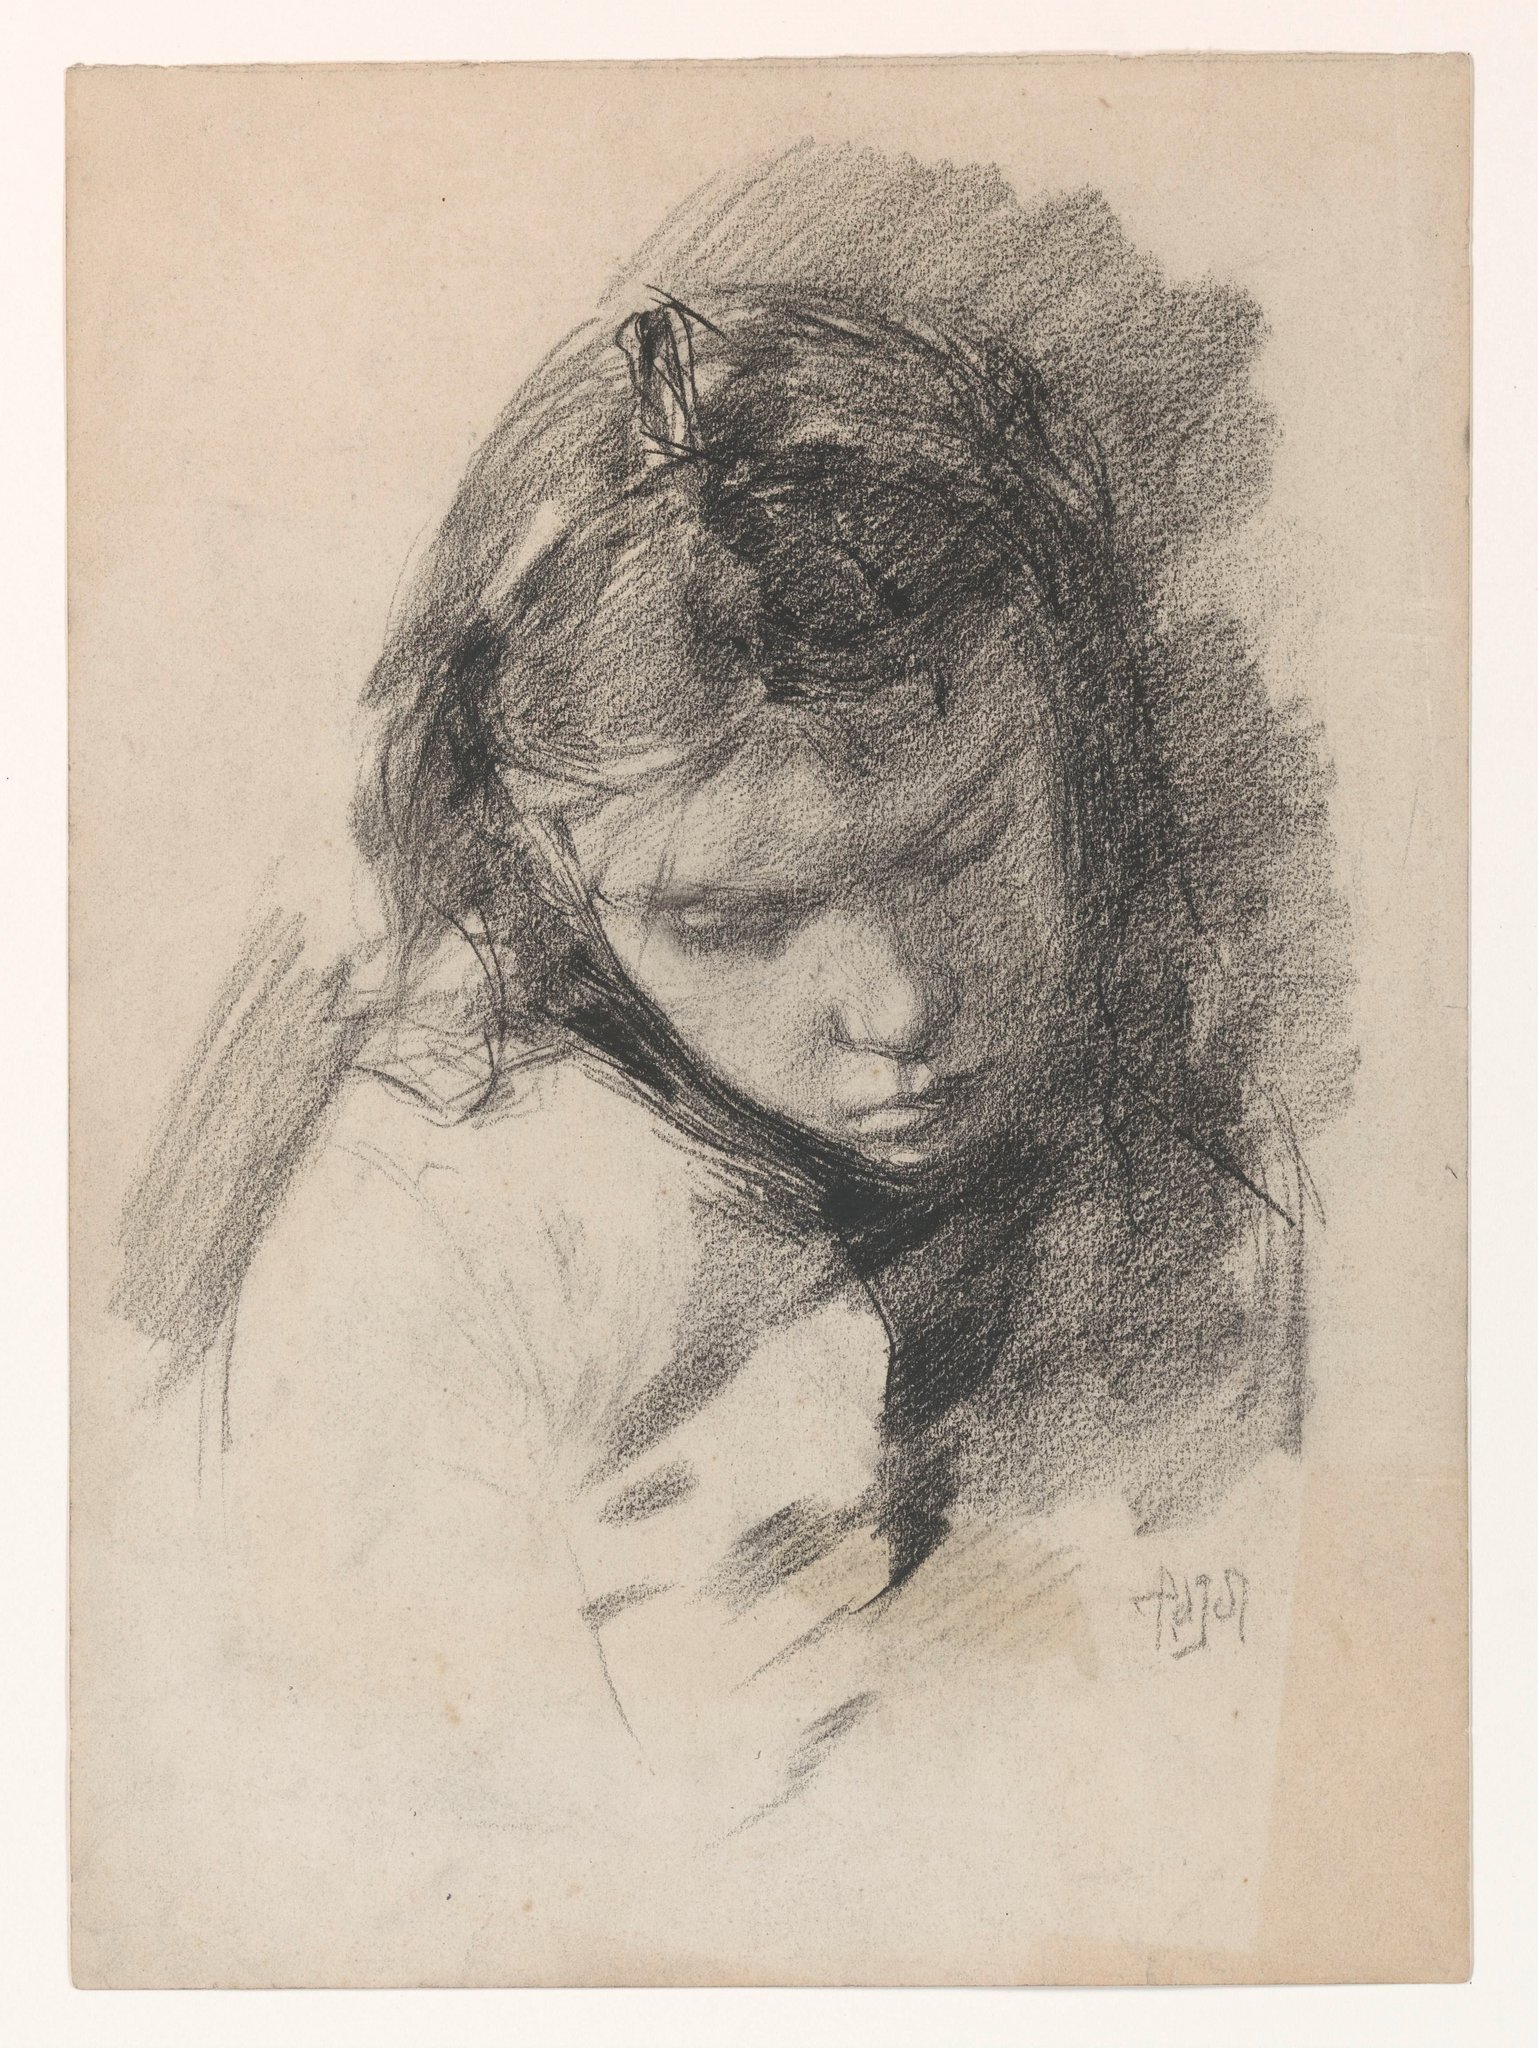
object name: drawing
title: Meisjeskopje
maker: pieter de josselin de jong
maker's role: draughtsman, painter, print maker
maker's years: 1861-1906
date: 1871-1906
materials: chalk, paper